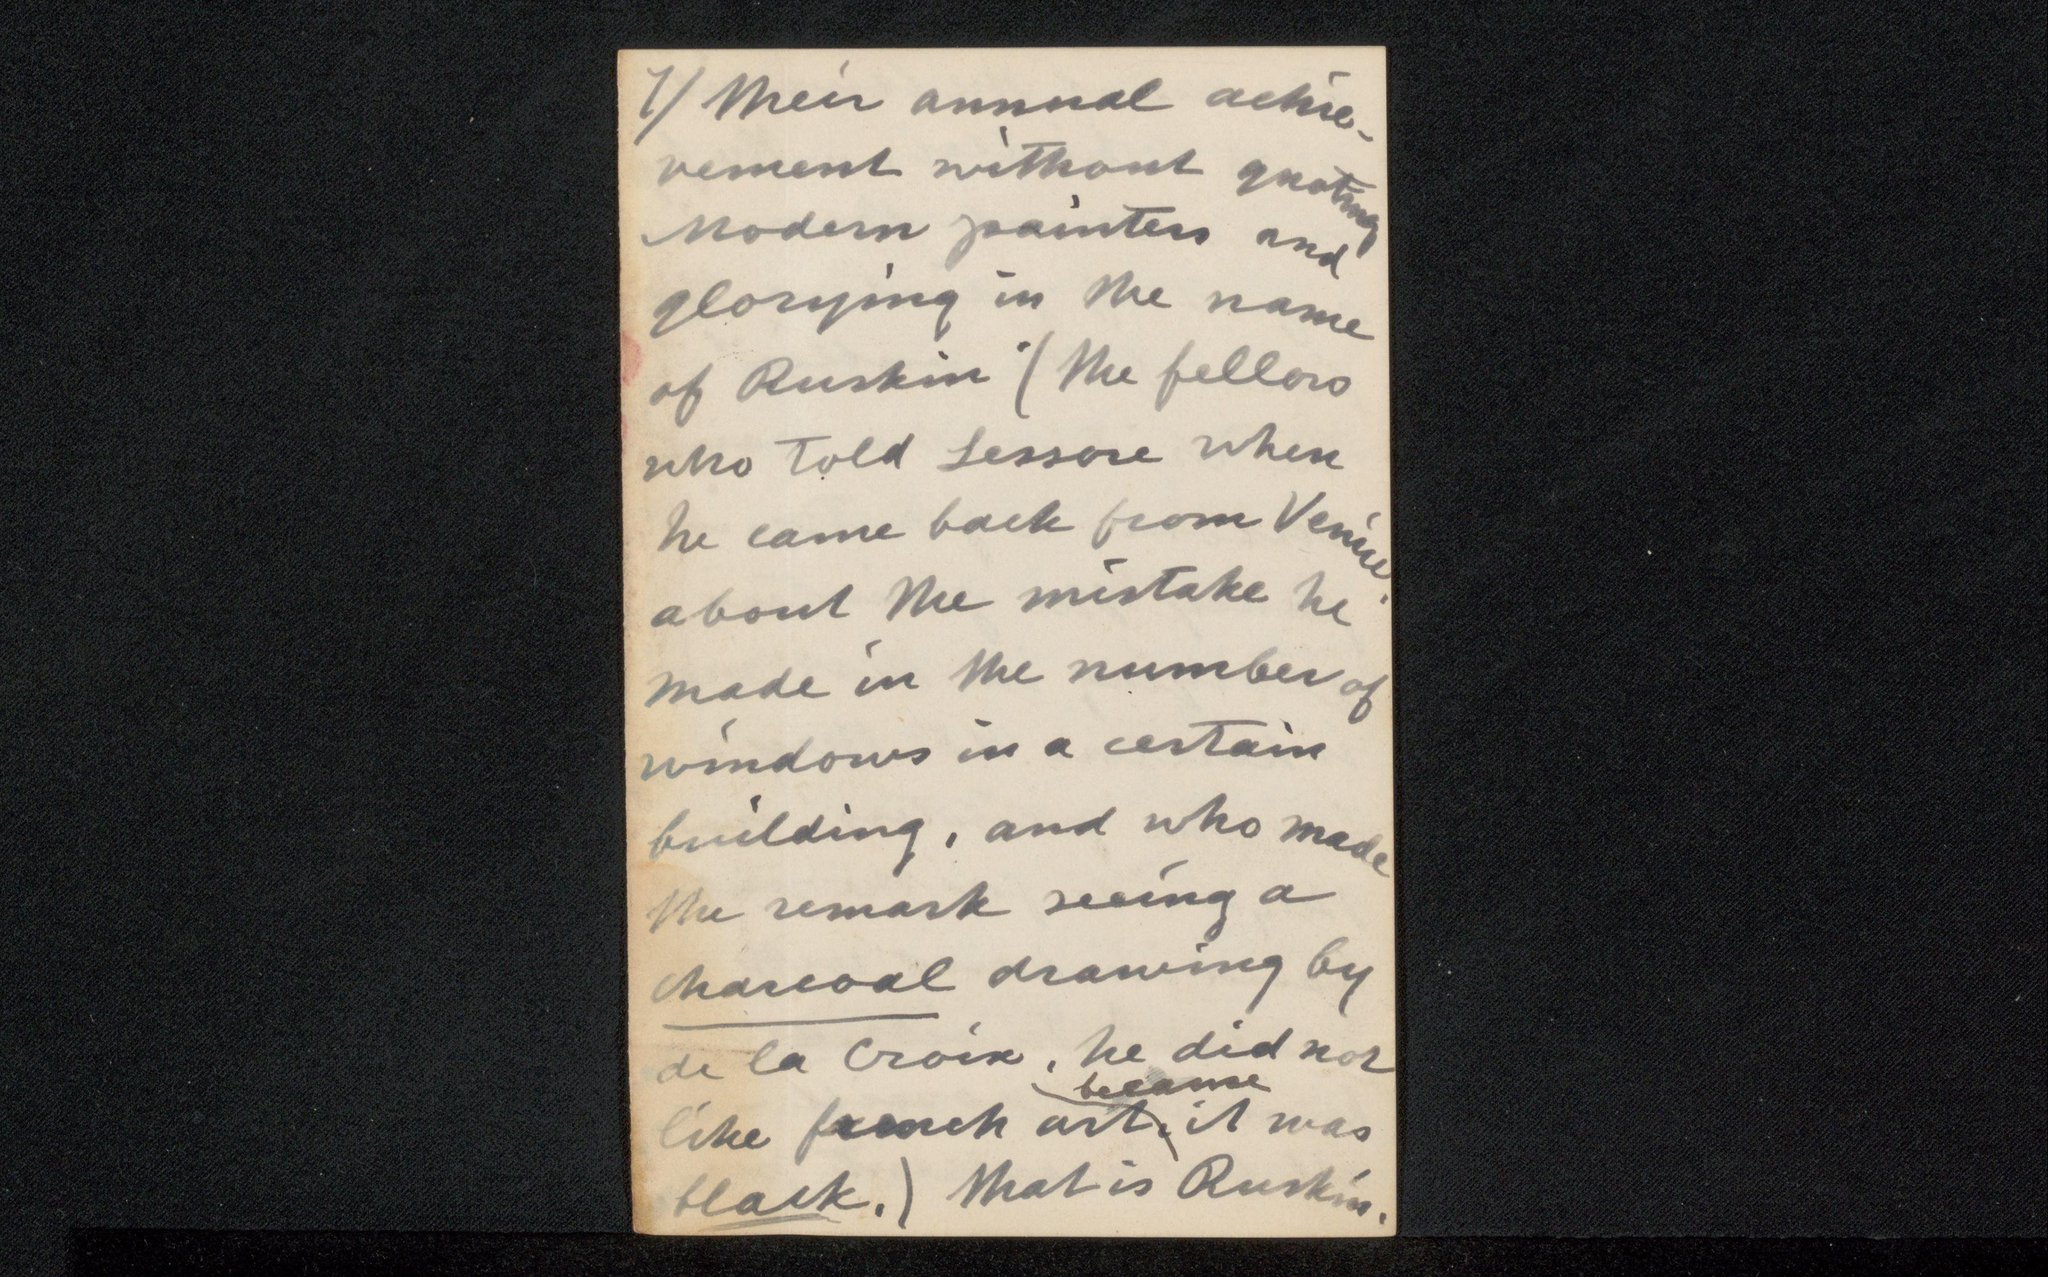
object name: letter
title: Brief aan Philip Zilcken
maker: matthijs maris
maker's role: draughtsman, painter, print maker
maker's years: 1839-1917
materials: ink, paper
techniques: pen, writing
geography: london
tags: paris, eugène delacroix, claude monet, rome, nicolas poussin, amsterdam, meindert hobbema, james abbott mcneill whistler, john ruskin, joseph mallord william turner, the hague, painter, draughtsman, philip zilcken, drawing, photography, cinematography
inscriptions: collector's mark: ‘RPK’, watermark